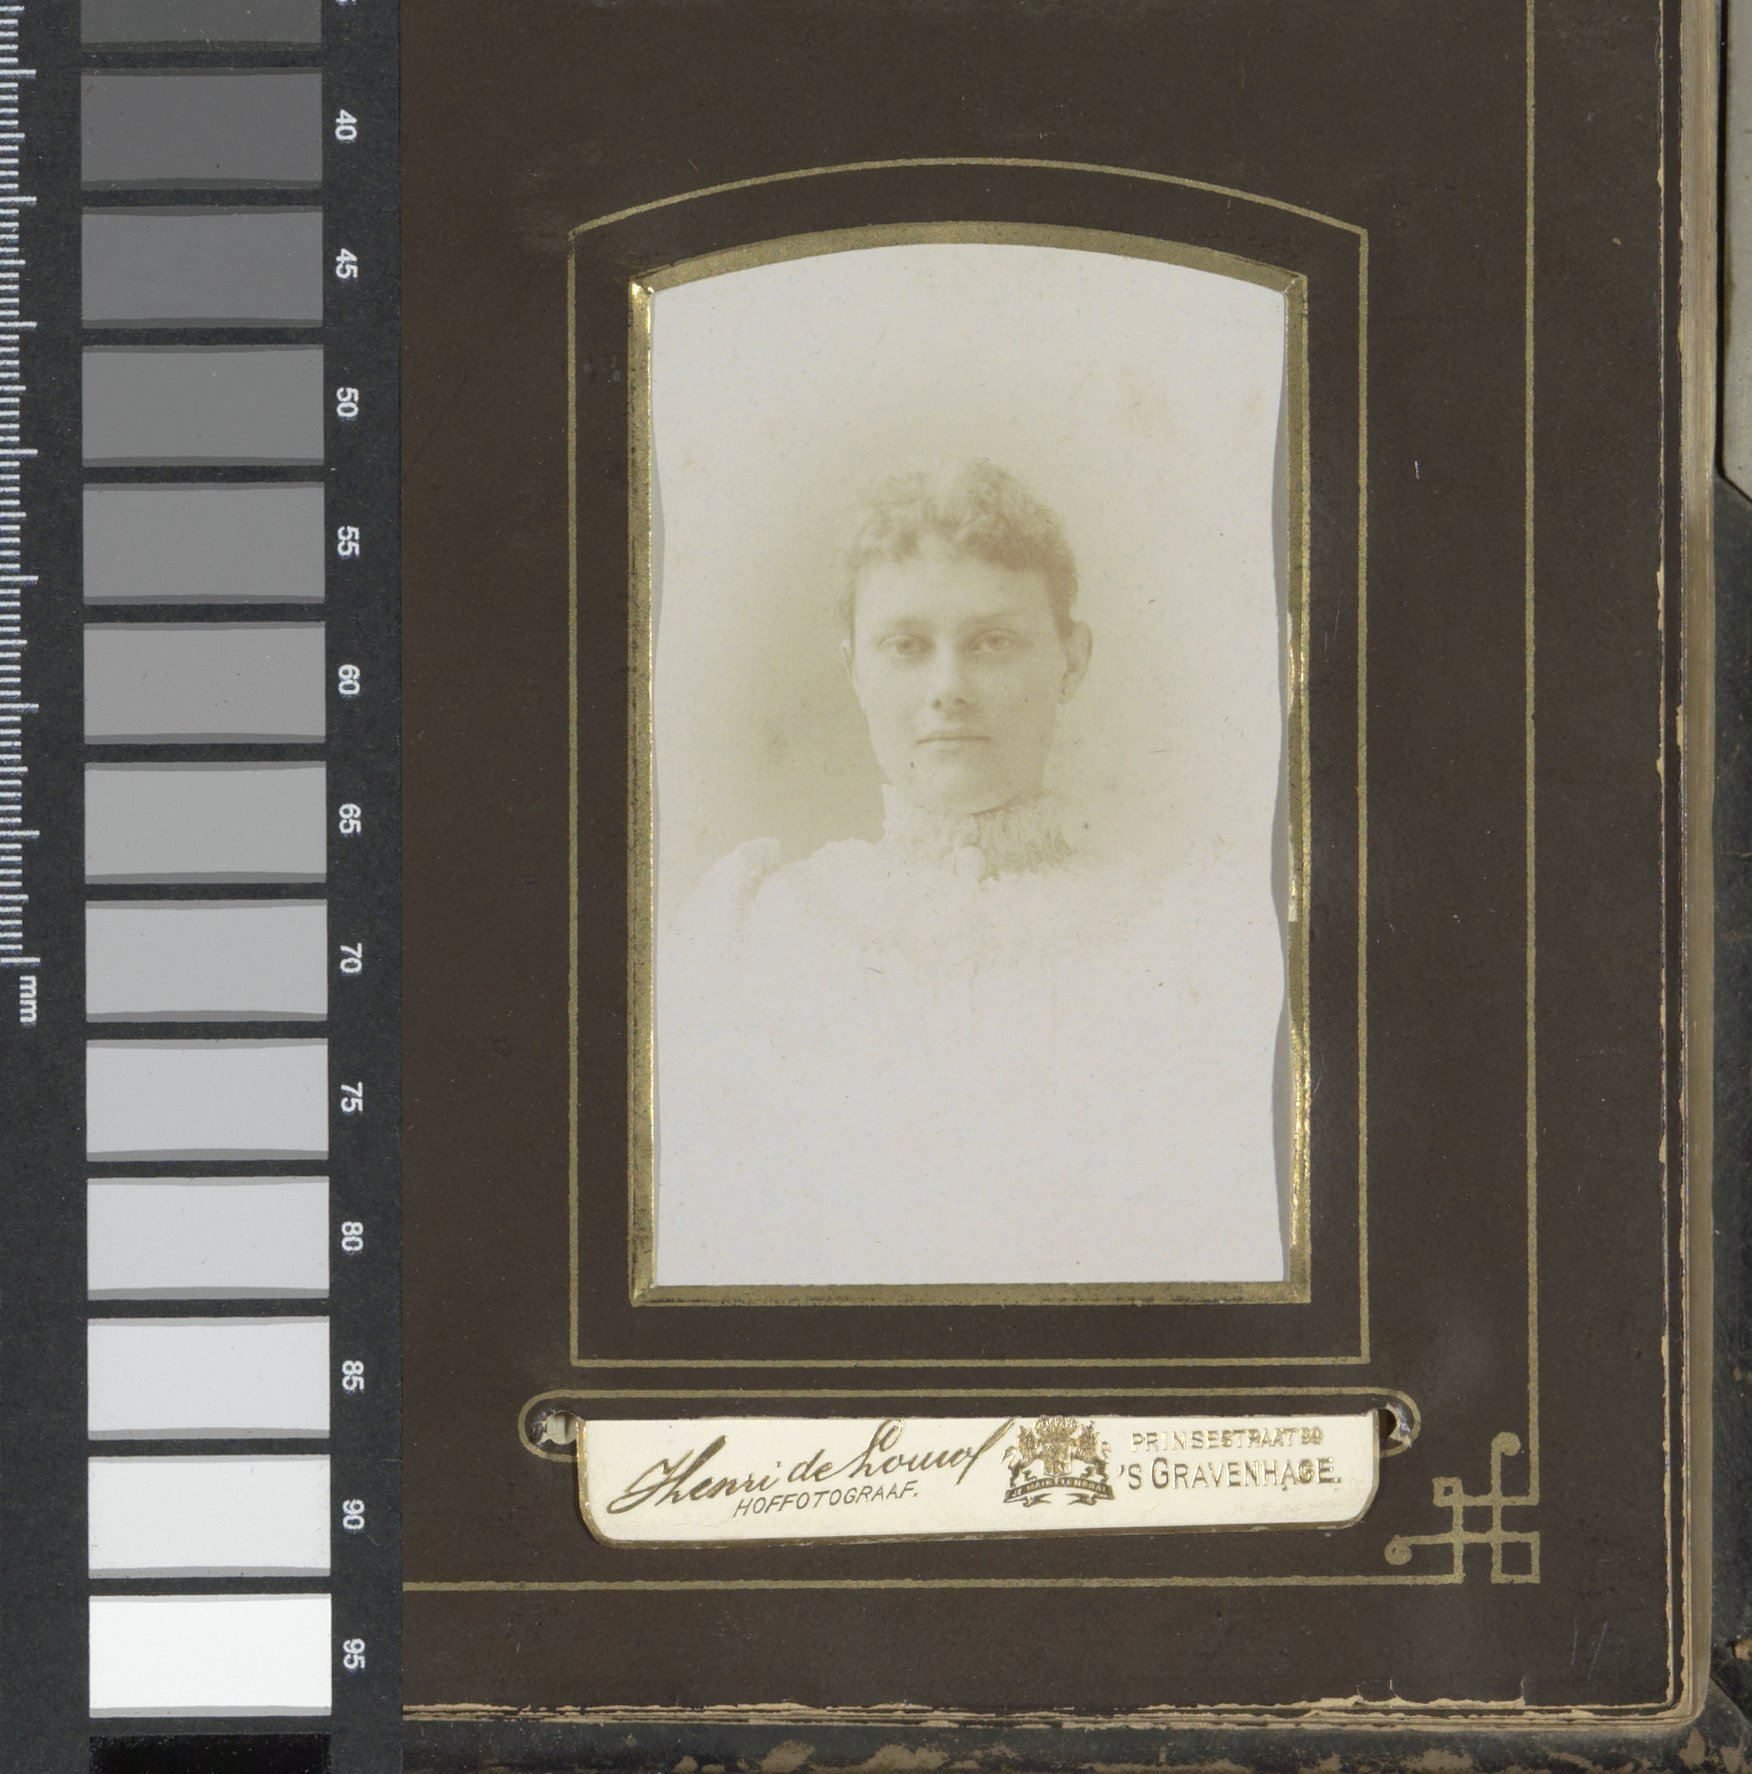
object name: album leaf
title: Portret van een vrouw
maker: henri de louw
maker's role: fotograaf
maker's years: 1851-1944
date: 1891-1910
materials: cardboard, paper, photographic support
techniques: collodion silver print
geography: the hague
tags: adult woman, historical persons not known by name - bb - woman, the hague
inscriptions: address: ‘Prinsestraat 99 's Gravenhage.’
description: Onderdeel van Fotoalbum van de families Matthes, Doorman en Van Thiel.